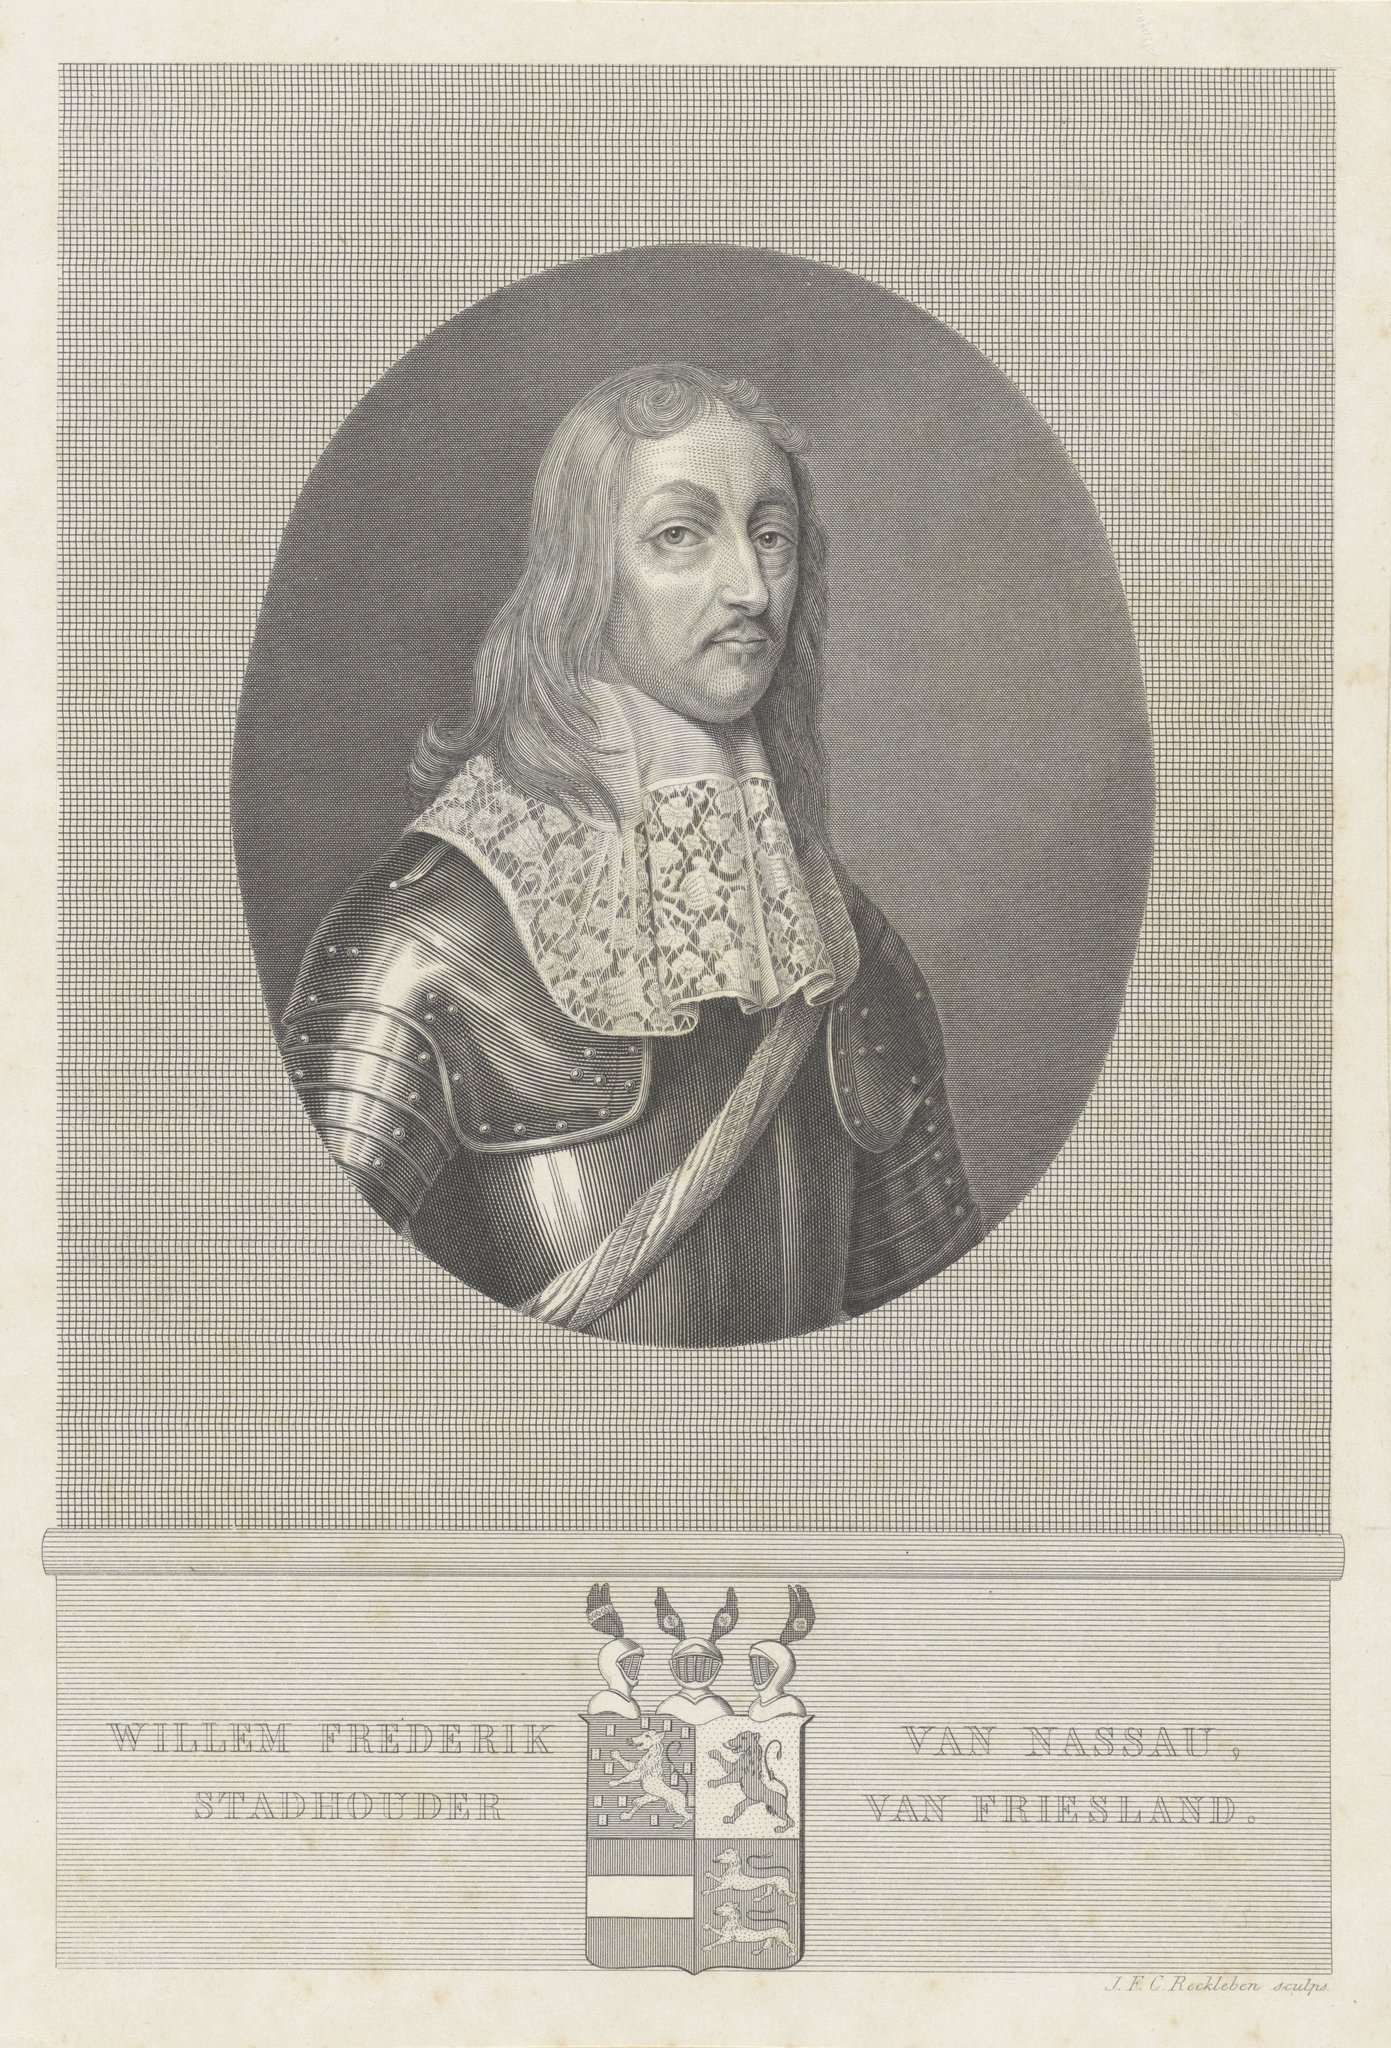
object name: print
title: Portret van Willem Frederik, graaf van Nassau-Dietz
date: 1840-1884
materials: paper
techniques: engraving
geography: amsterdam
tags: arnhem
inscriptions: collector's mark: Lugt 2228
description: De hier vermelde titel verwijst naar de hoogst verkregen titel van de geportretteerde, niet per se naar de titel die de geportretteerde op deze voorstelling draagt. Prent uit: Arend, Johannes Pieter. Algemeene geschiedenis des vaderlands van de vroegste tijden tot op heden. Amsterdam: J.F. Schleijer, 1840-1884.